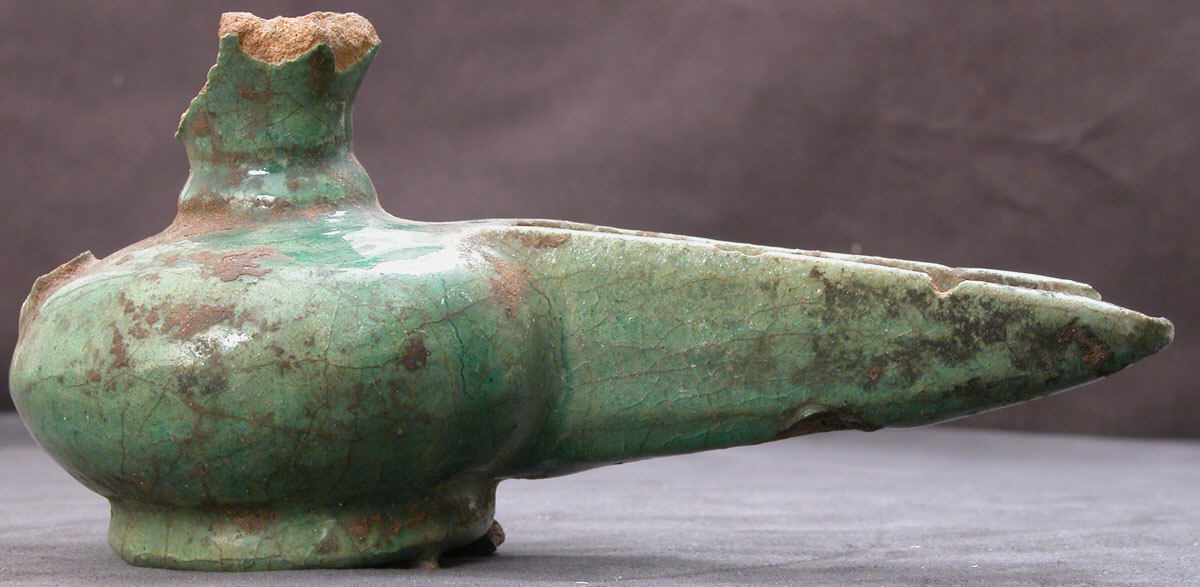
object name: lamp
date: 1101-1300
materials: earthenware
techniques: glazing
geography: syria